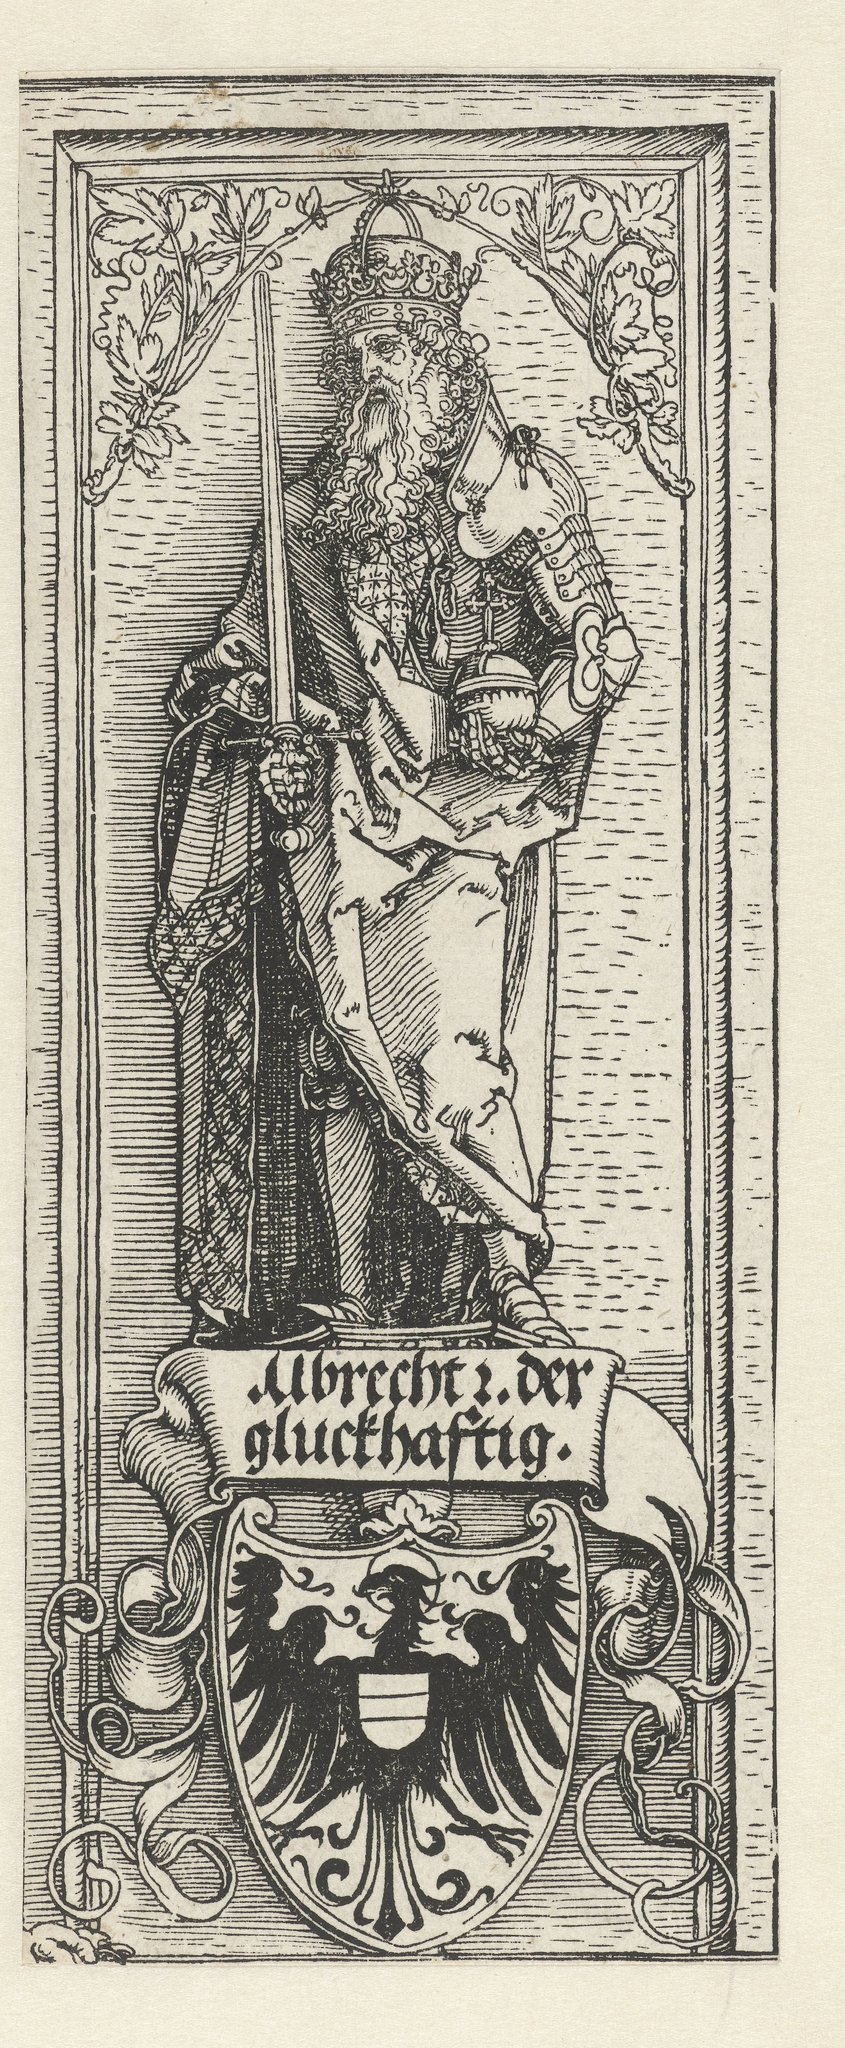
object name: print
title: Albrecht de Gelukkige (Albrecht III de Kloekmoedige, hertog van Saksen?)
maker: albrecht dürer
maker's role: draughtsman, painter, print maker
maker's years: 1471-1528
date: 1515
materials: paper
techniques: woodcut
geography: nuremberg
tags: maximilian i (holy roman emperor), coat of arms (symbol of sovereignty), crown (symbol of sovereignty), orb (symbol of sovereignty; sphere with cross on top), ruler, sovereign, armorial bearing, heraldry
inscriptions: collector's mark: Lugt 240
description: Albrecht de Gelukkige ('gluckhaftig' - wellicht gaat het om Albrecht III de Kloekmoedige, hertog van Saksen), staand met een zwaard in de ene hand en een rijksappel in de andere hand. Onder zijn portret zijn naam in het Duits in gotisch schrift; daaronder zijn wapenschild. Detail van de triomfboog van keizer Maximiliaan I.